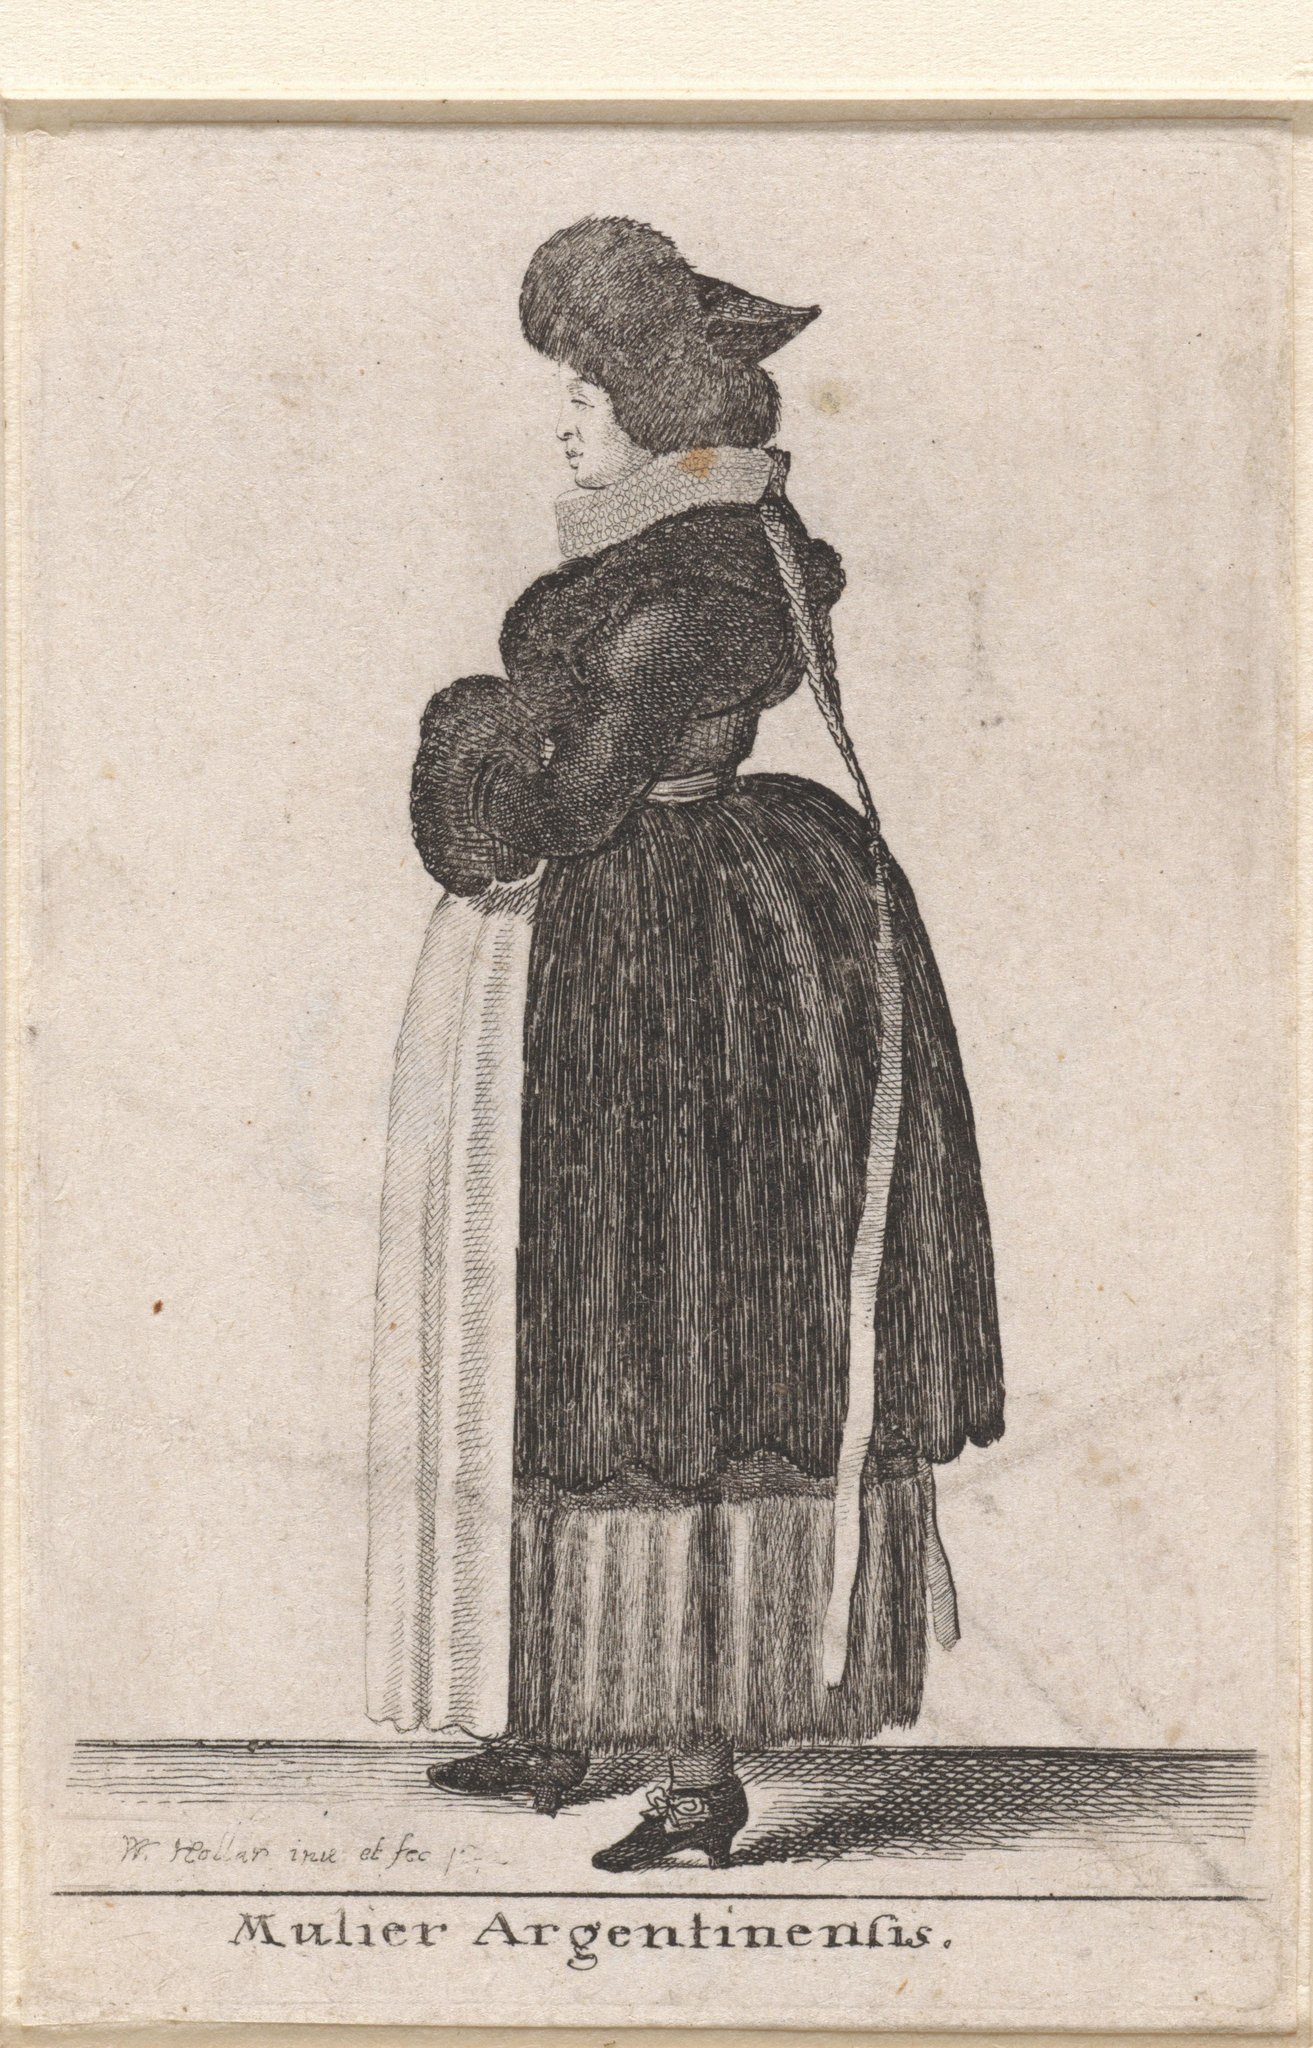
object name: costume print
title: Aula Veneris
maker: wenceslaus hollar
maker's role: draughtsman, print maker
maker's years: 1607-1677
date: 1642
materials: paper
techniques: etching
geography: london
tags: europeans: germans (+ women), skirt (underskirt) (+ women's clothes), clothes, costume (+ women's clothes), neck-gear ~ clothing (with name) (+ women's clothes), skirt (+ women's clothes), muff (+ fur used for clothes), apron (+ women's clothes), clothing for the upper part of the body (with name) (+ women's clothes), head-gear: cap (+ fur used for clothes)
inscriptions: collector's mark: Lugt 240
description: Vrouw uit Straatsburg, in profiel naar links, met beide handen in een bontmof. Op het hoofd een muts met brede bontrand en eindigend in een punt op het achterhoofd. Een smalle, vijf lagen dikke plooikraag met sluiting in de nek. Vanaf de nek twee afhangende gevlochten koorden eindigend in een oog, waaraan twee losse linten. Een kort nauwsluitend jak met brede bontkraag en nauwsluitende lange mouwen. Hieronder een rijglijf op een knielange, geschulpte rok waaronder een enkellange rok met brede bontrand. Het lijfje is afgezet met bont, een donkere overrok, waaronder een lichte onderrok. Gerimpeld, wit schort. Open schoenen met striksluiting en hak.